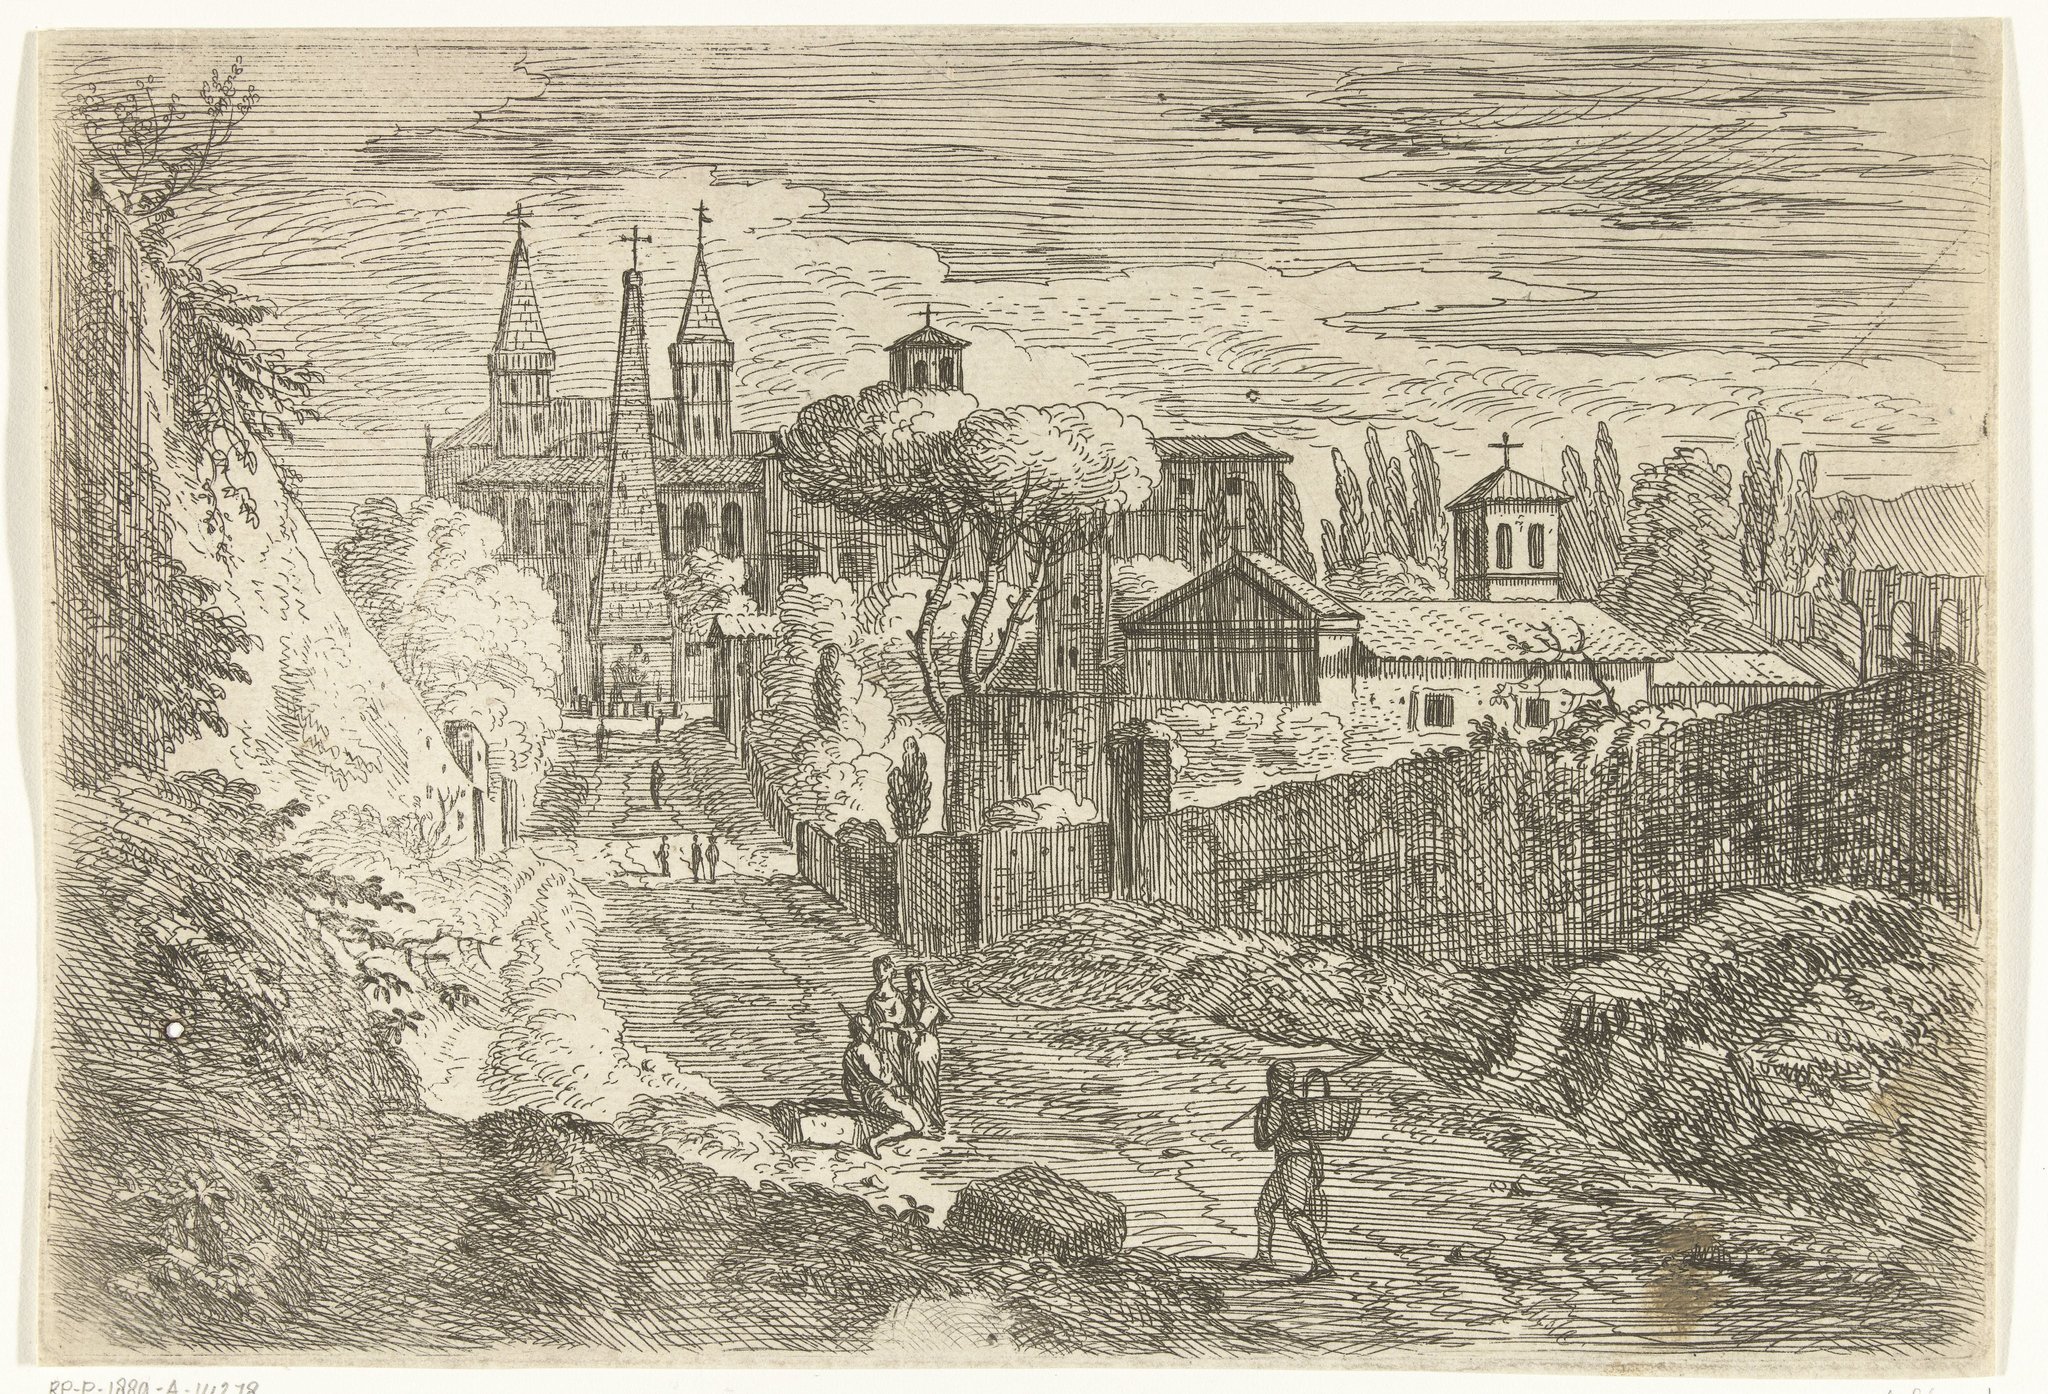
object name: print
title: De man met de mand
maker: jan frans van bloemen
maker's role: draughtsman, print maker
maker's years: 1662-1749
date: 1689-1749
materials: paper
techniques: etching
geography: rome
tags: city-walls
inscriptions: collector's mark: Lugt 2228